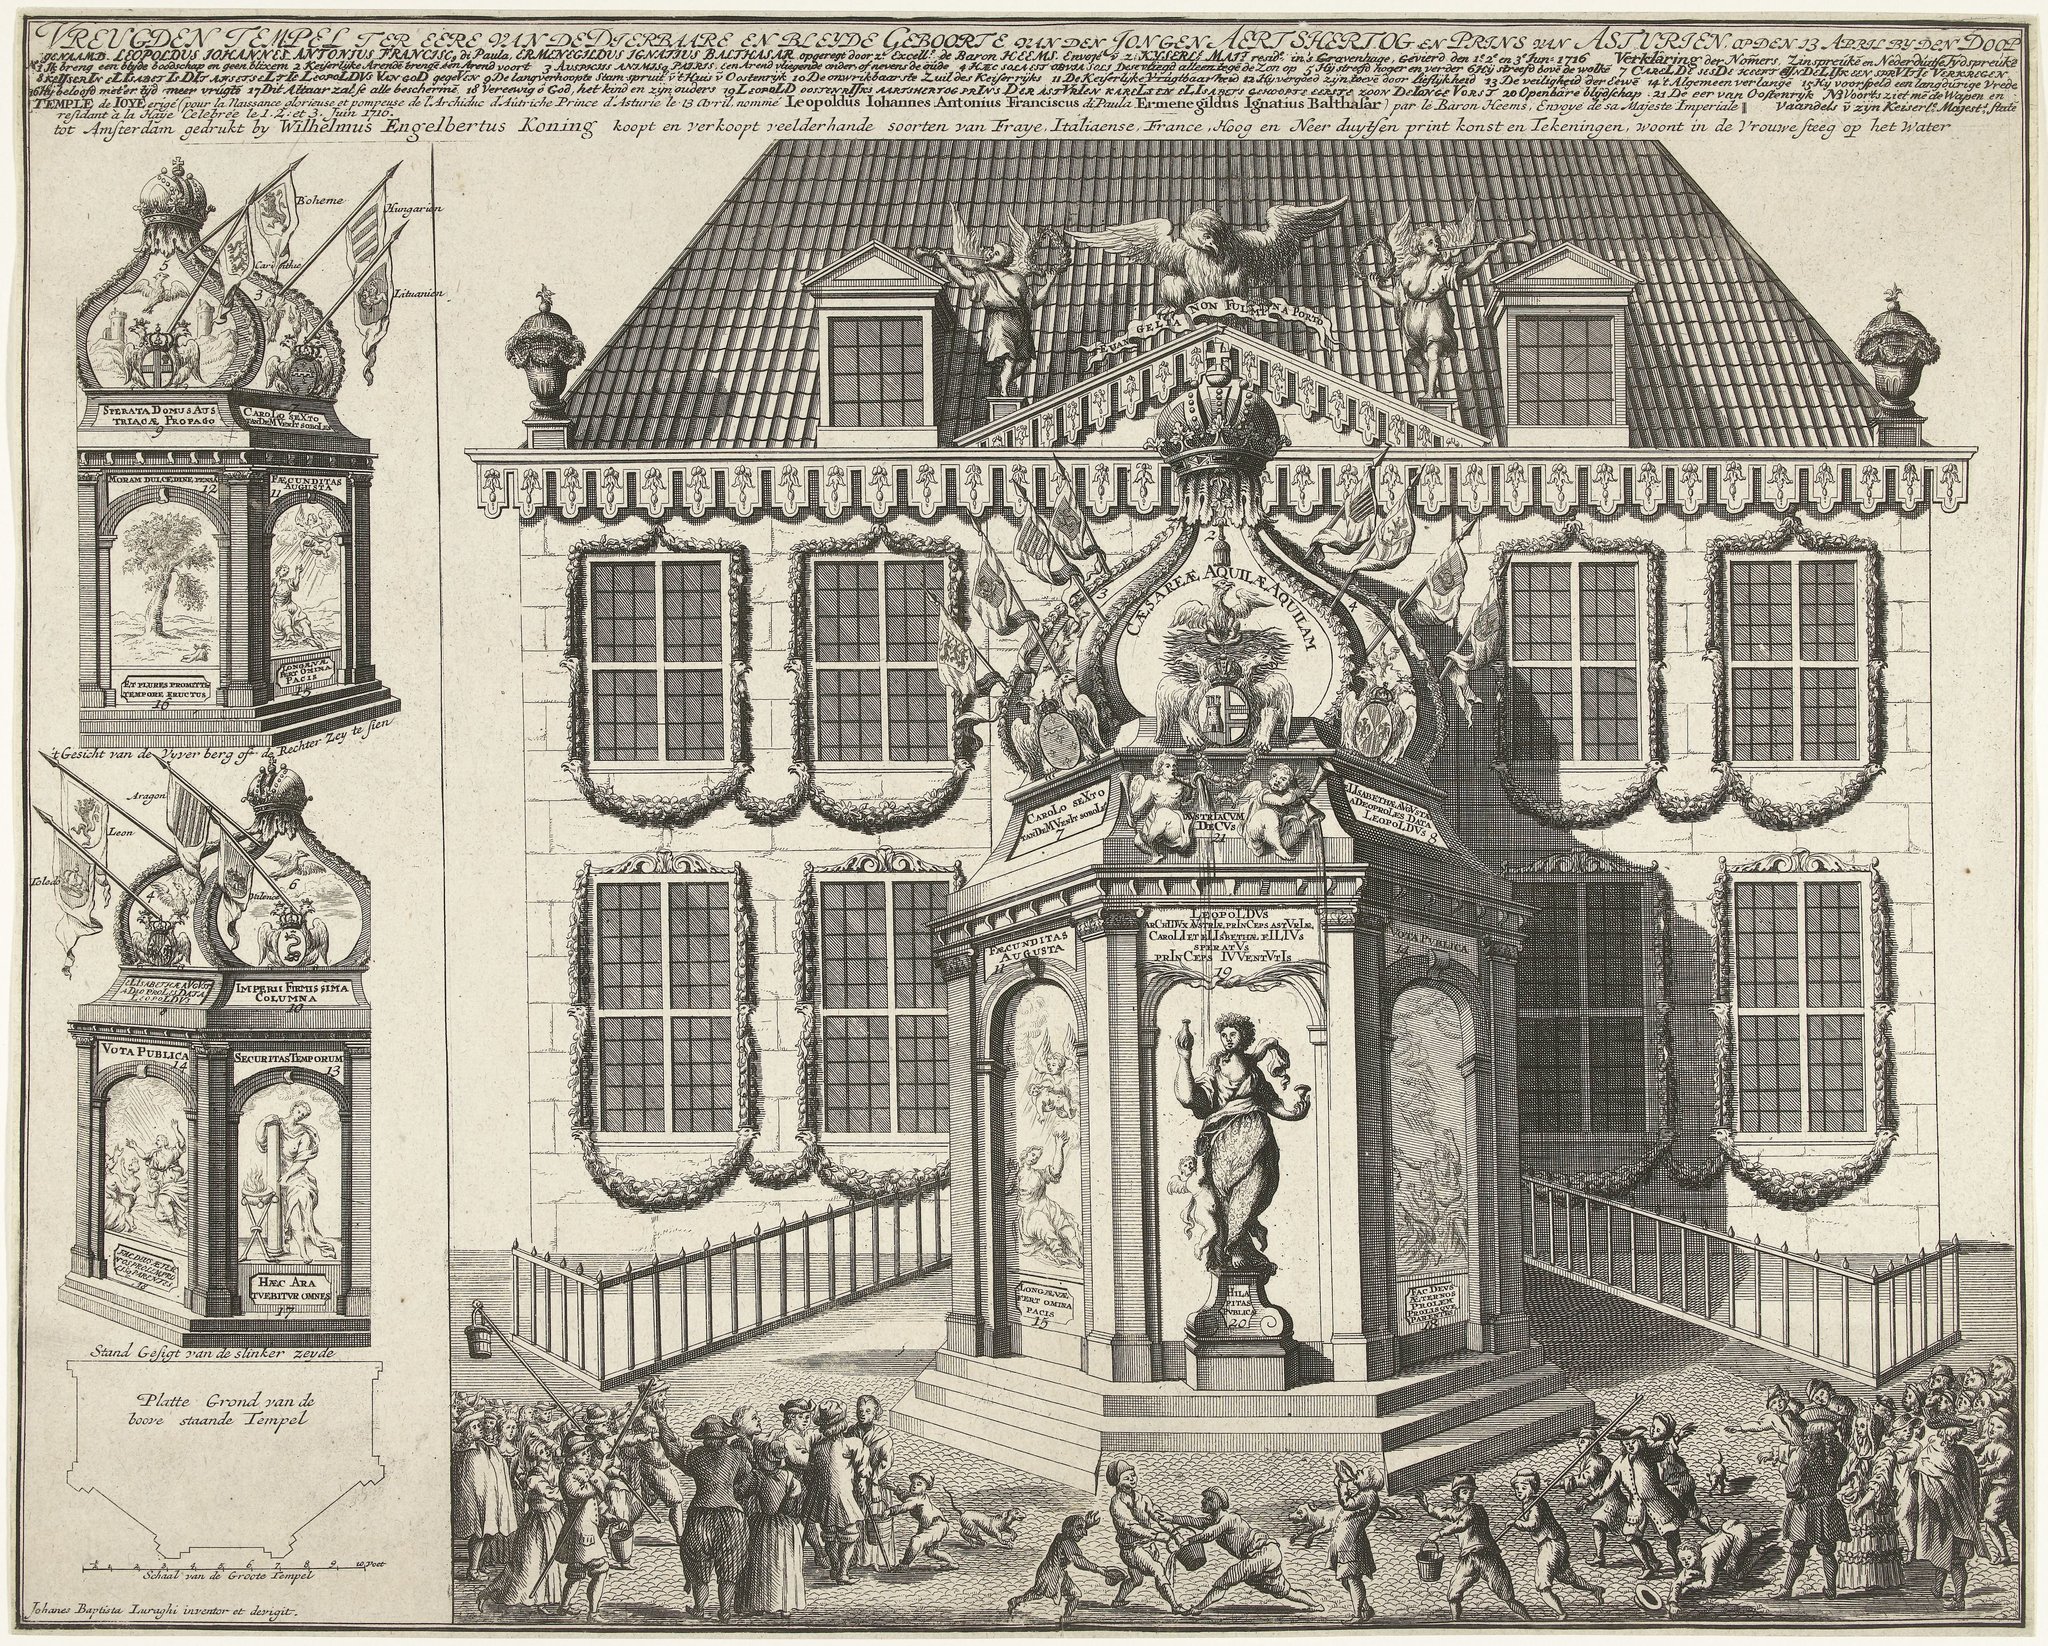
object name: print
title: Vreugden tempel ter eere van de dierbaare en bleyde geboorte van den jongen aertshertog en prins van Asturien, op den 13 april by den doop genaamd Leopoldus Johannes (...) opgeregt door z. excelle. de baron Heems (...) gevierd den 1e, 2e en 3e jun. 1716 / Temple de ioye erigé (pour la naissance glorieuse et pompeuse de l'archiduc d'Aûtriche prince d'Asturie le 13 avril, nommé Leopoldus Iohannes (...)) par le baron Heems (...) celebrée le 1, 2; et 3, juin 1716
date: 1716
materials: paper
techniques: engraving, etching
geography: northern netherlands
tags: public festivities at birth of royal persons (+ festive decoration ~ festive activities), the hague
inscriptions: collector's mark: Lugt 2228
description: Tempel opgericht in juni 1716 voor het huis van de keizerlijke ambassadeur Arnold baron von Heems te Den Haag ter ere van de geboorte op 13 april 1716 van de jonge aartshertog Leopold Johan (de kroonprins overleed in hetzelfde jaar). Uitbouw versierd met allegorische figuren, wapens en vaandels. Voor het huis verzamelen bezoekers zich met emmers aan stokken om de wijn uit het fontein op te vangen. Links enkele details van de feesttempel, boven de titel met Franse vertaling en de legenda 1-21.